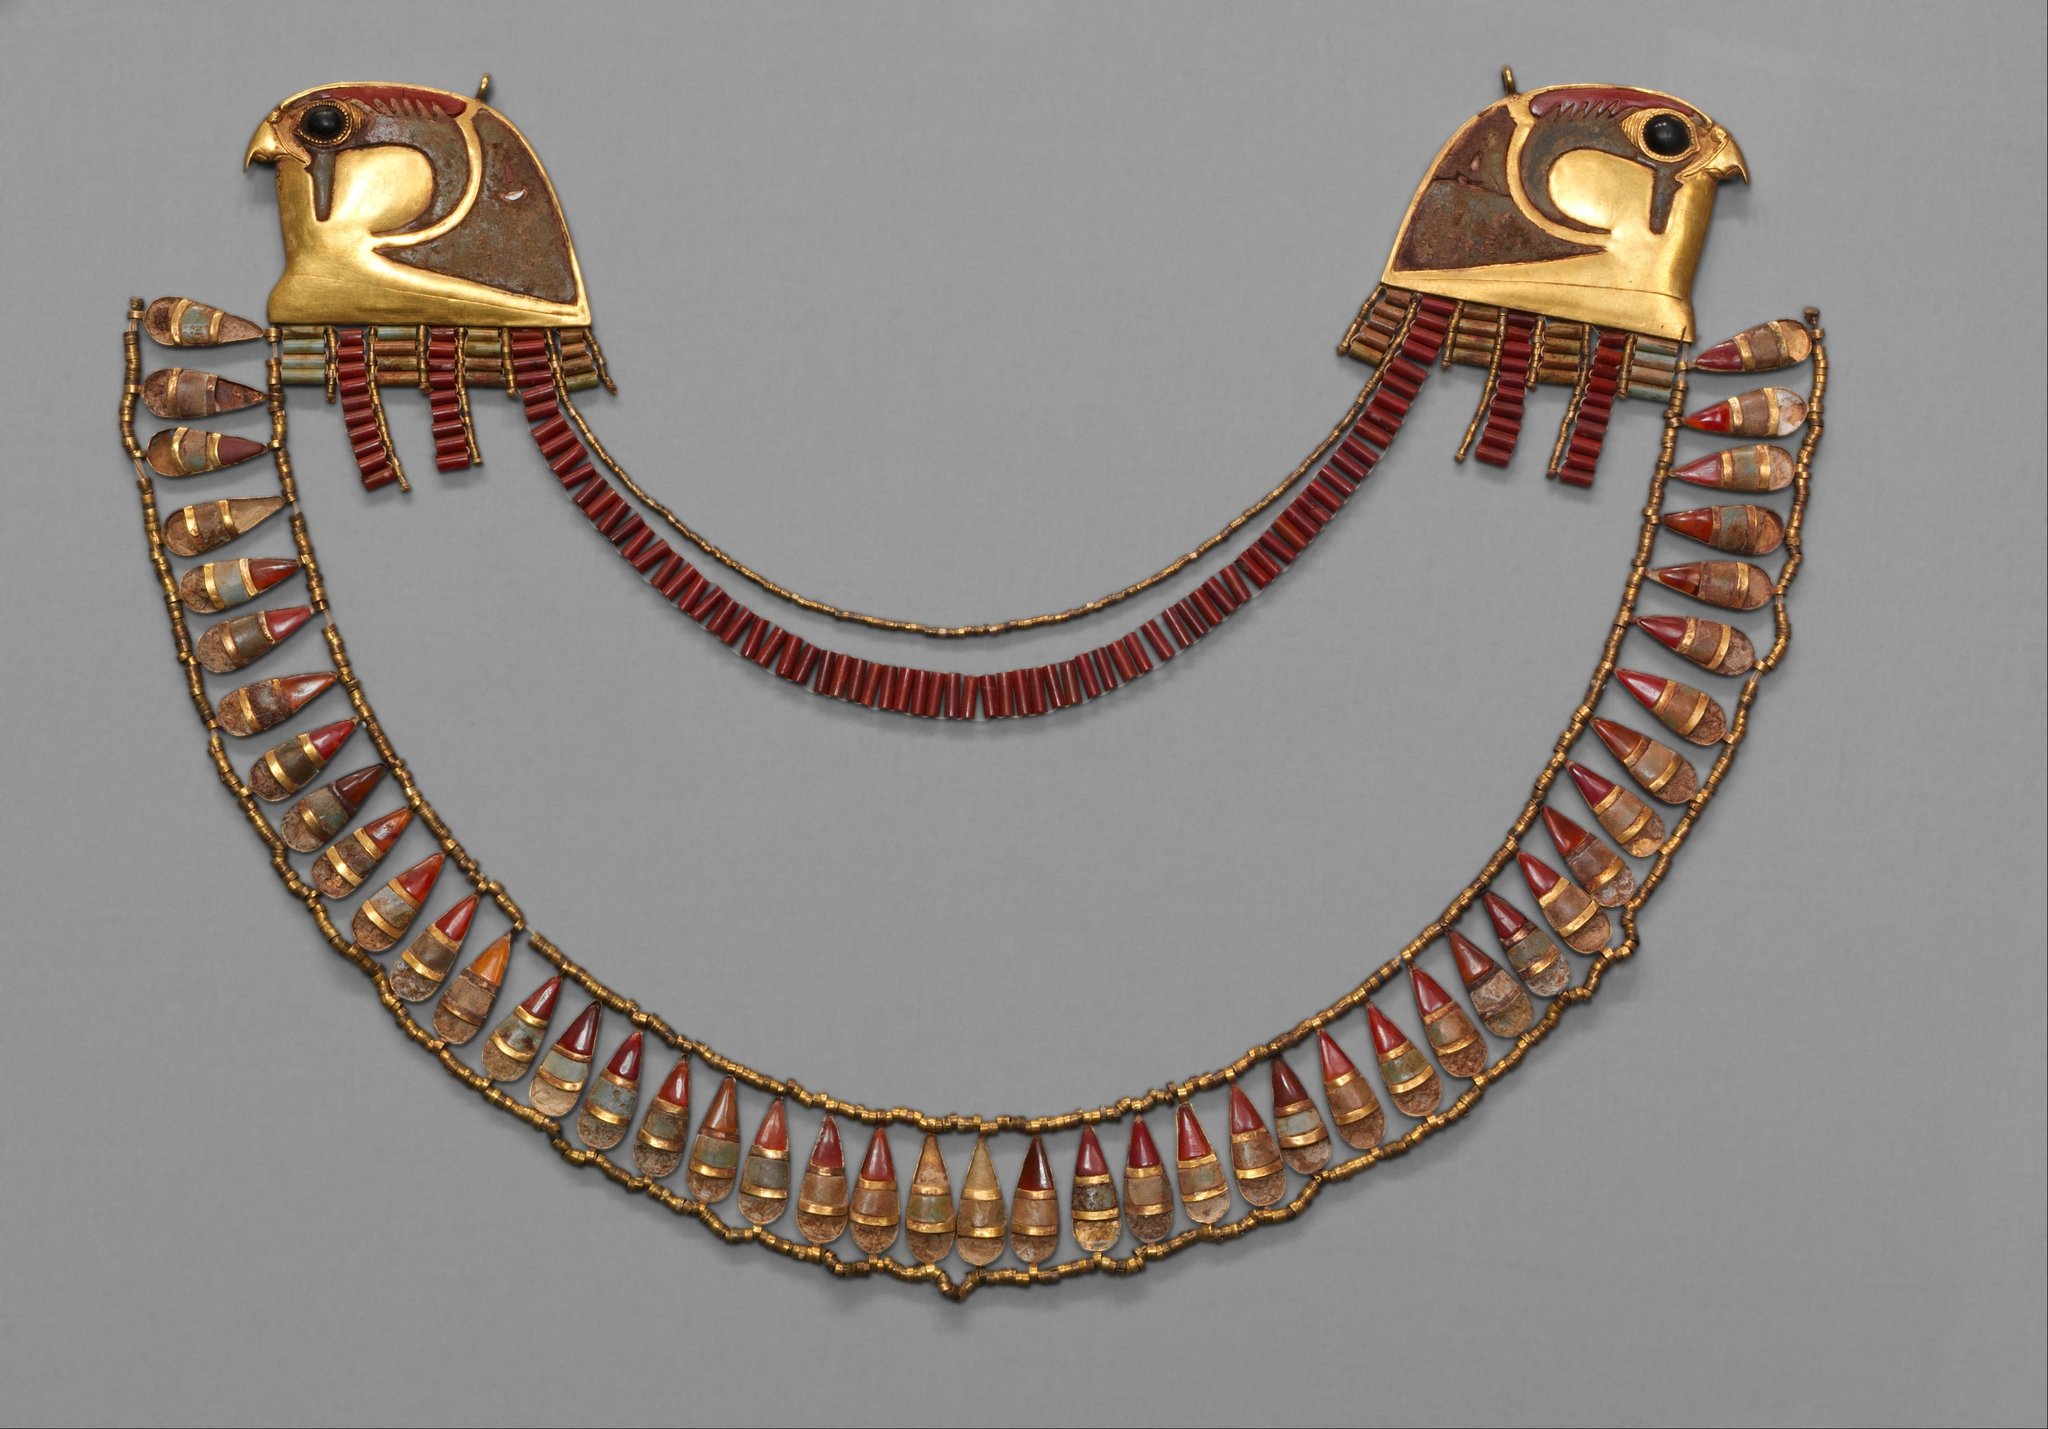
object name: broad collar, necklace, falcon terminal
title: Broad Collar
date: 1479-1425 BCE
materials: gemstone, glass, gold, obsidian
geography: upper egypt, thebes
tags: falcons